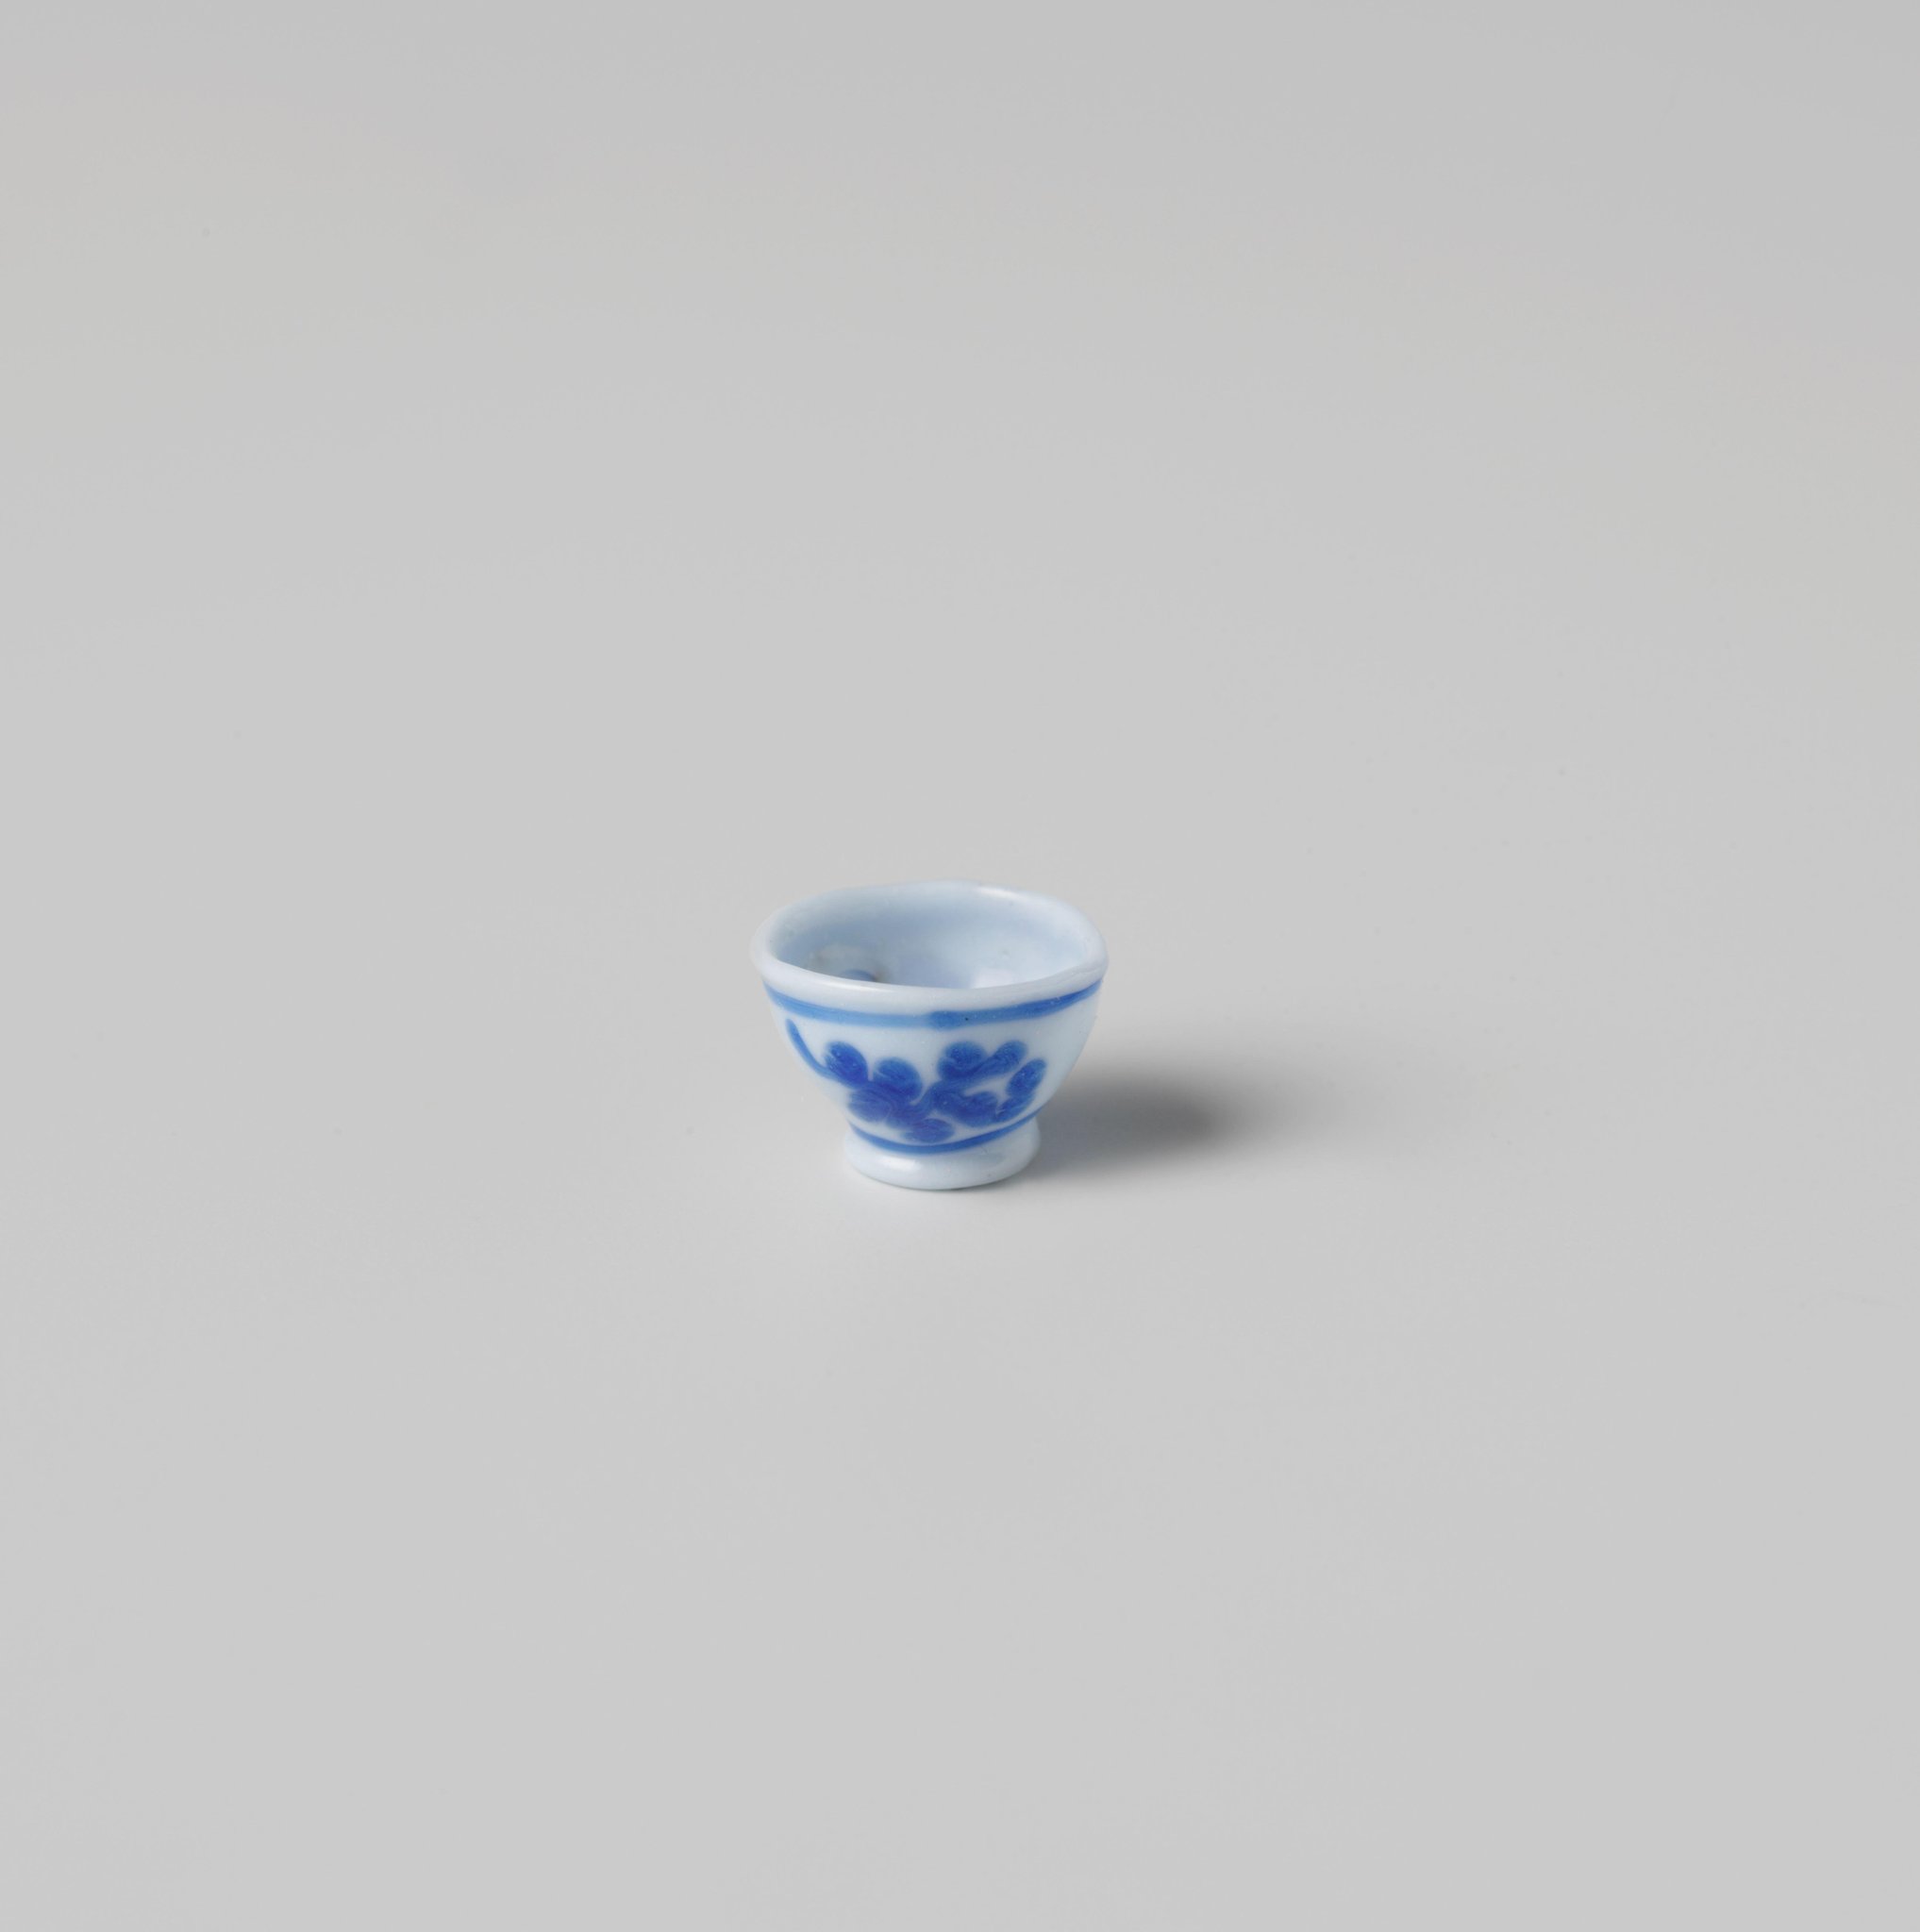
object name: miniature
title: Kom, wit, beschilderd in blauw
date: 1675-1699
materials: glass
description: Kom van melkglas met blauwe emailverf beschilderd. Imitatie chinees blauw porselein.